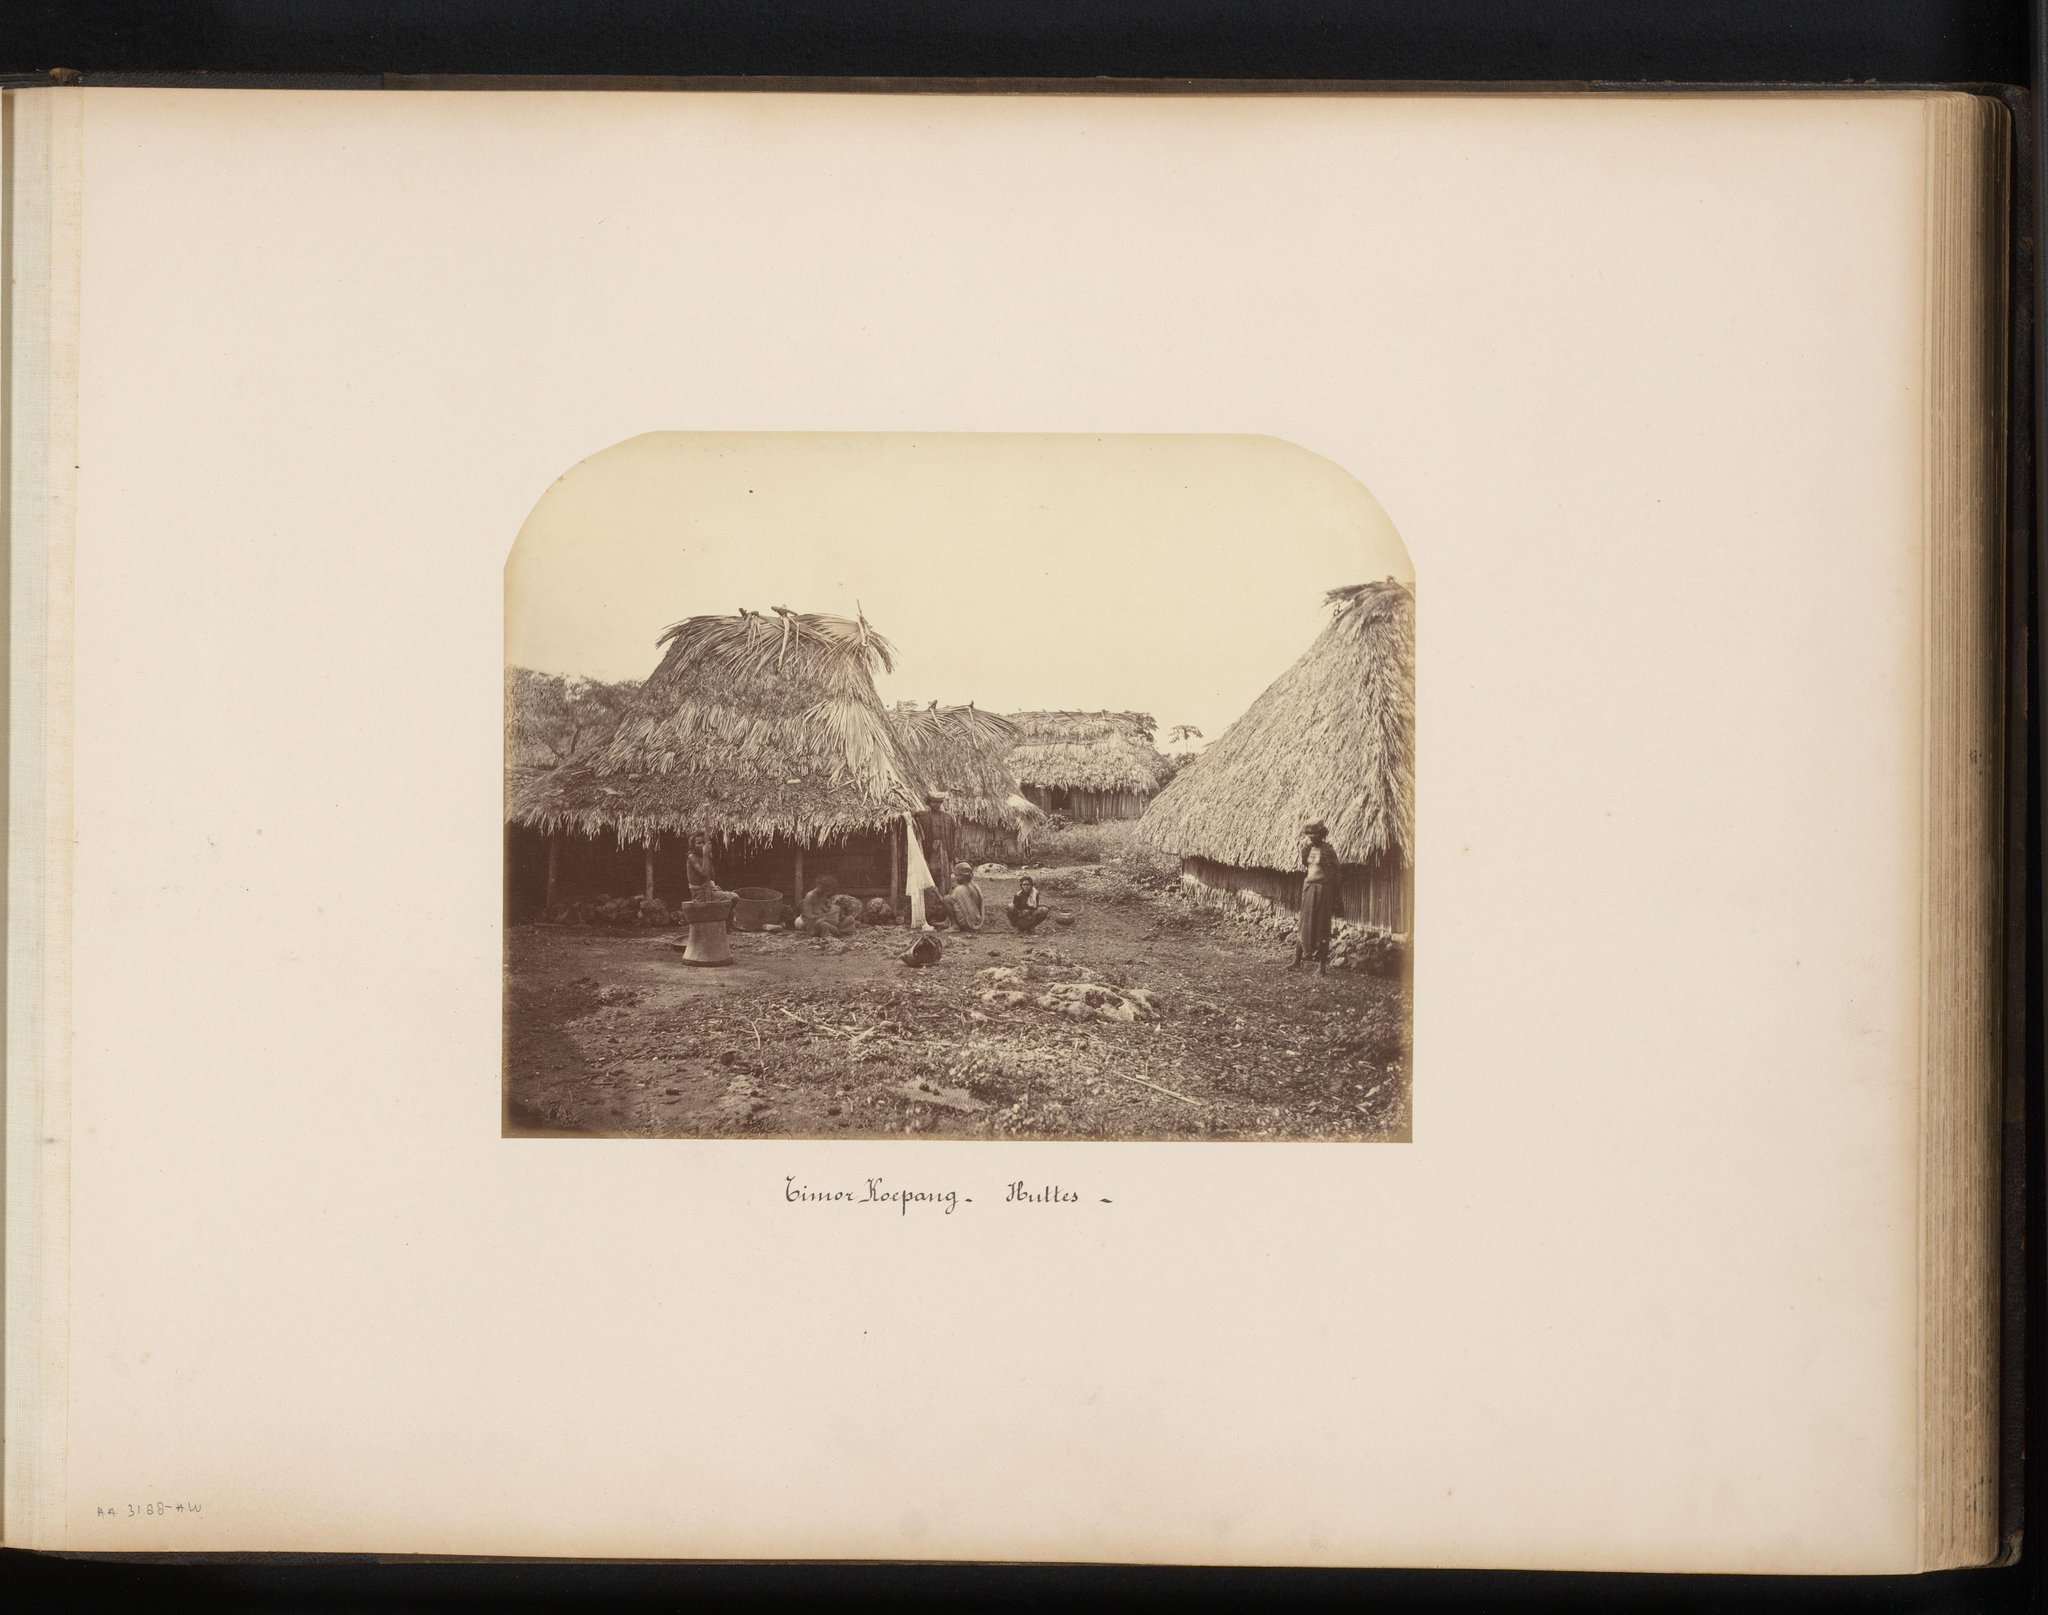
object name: photograph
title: Woningen en inwoners van een dorp in Kupang op Timor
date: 1880-1883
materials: photographic support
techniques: albumen print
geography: kupang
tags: rural housing, e.g. country-house, villa, cottage, village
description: Onderdeel van Reisalbum met opnames van bezienswaardigheden in Egypte, Nederlands-Indië, Singapore en Ceylon.